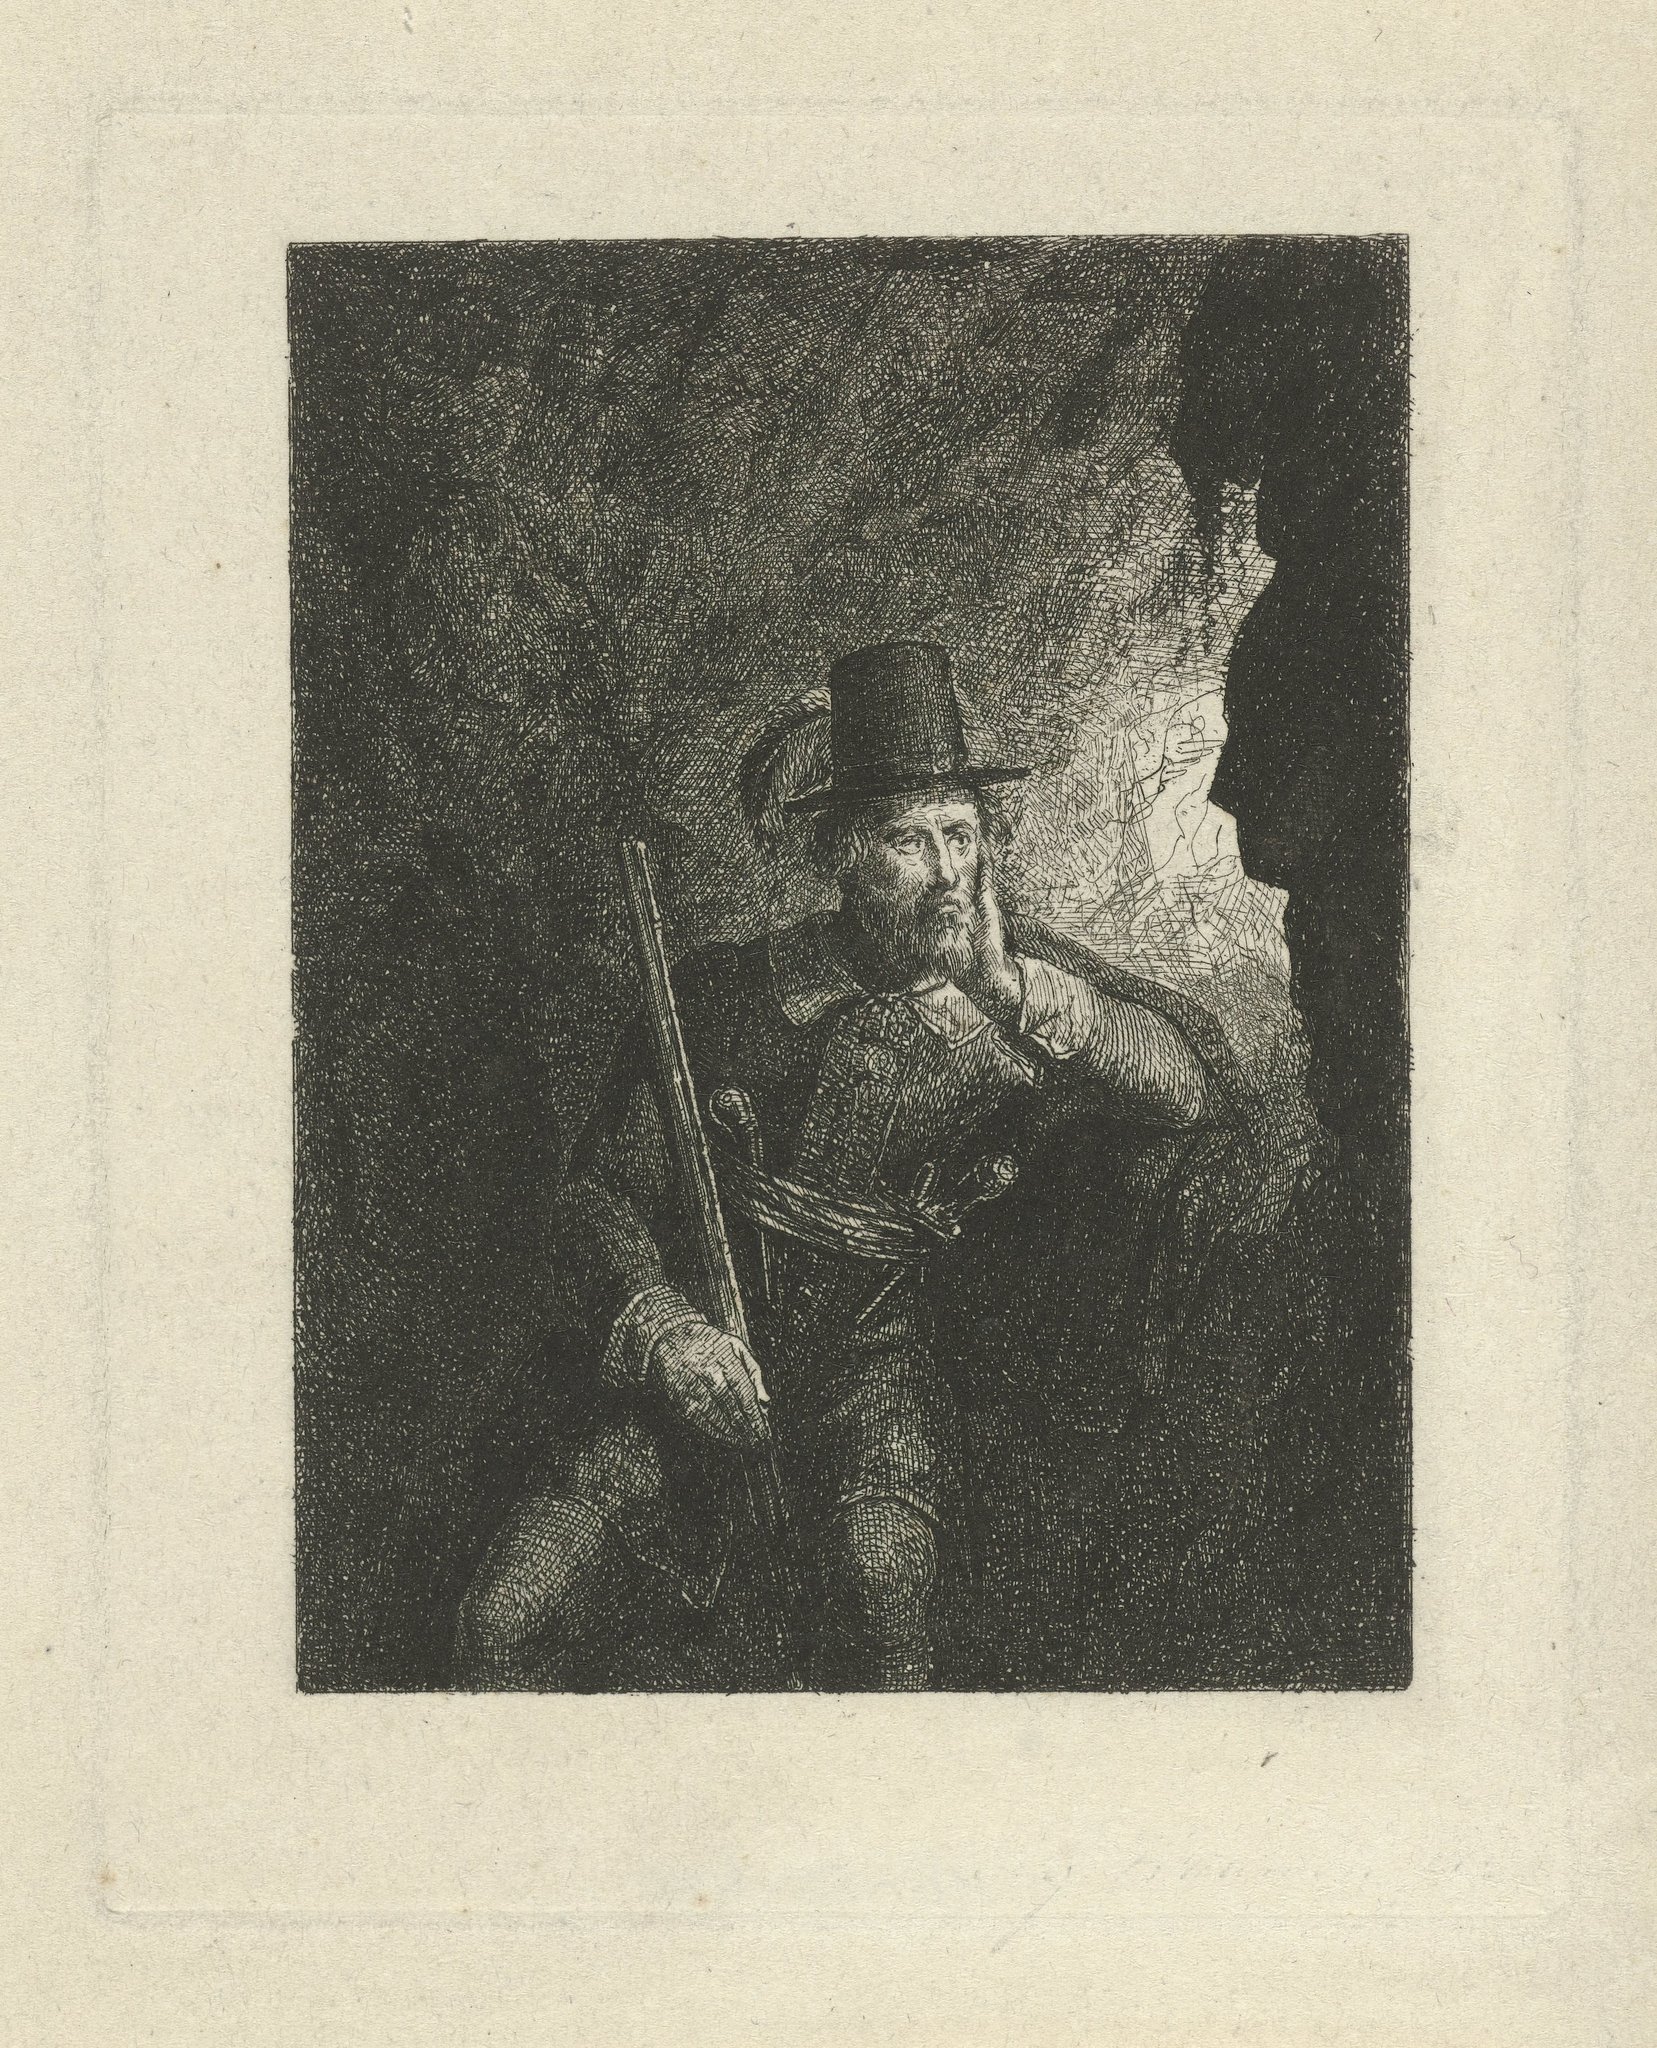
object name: print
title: Gewapend rover in een grot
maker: george gillis haanen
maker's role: draughtsman, painter, print maker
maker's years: 1807-1881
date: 1817-1879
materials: paper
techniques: etching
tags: robber, robber's cave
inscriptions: collector's mark: Lugt 2228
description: Een man met een geweer en twee pistolen zit in een grot en kijkt naar buiten.